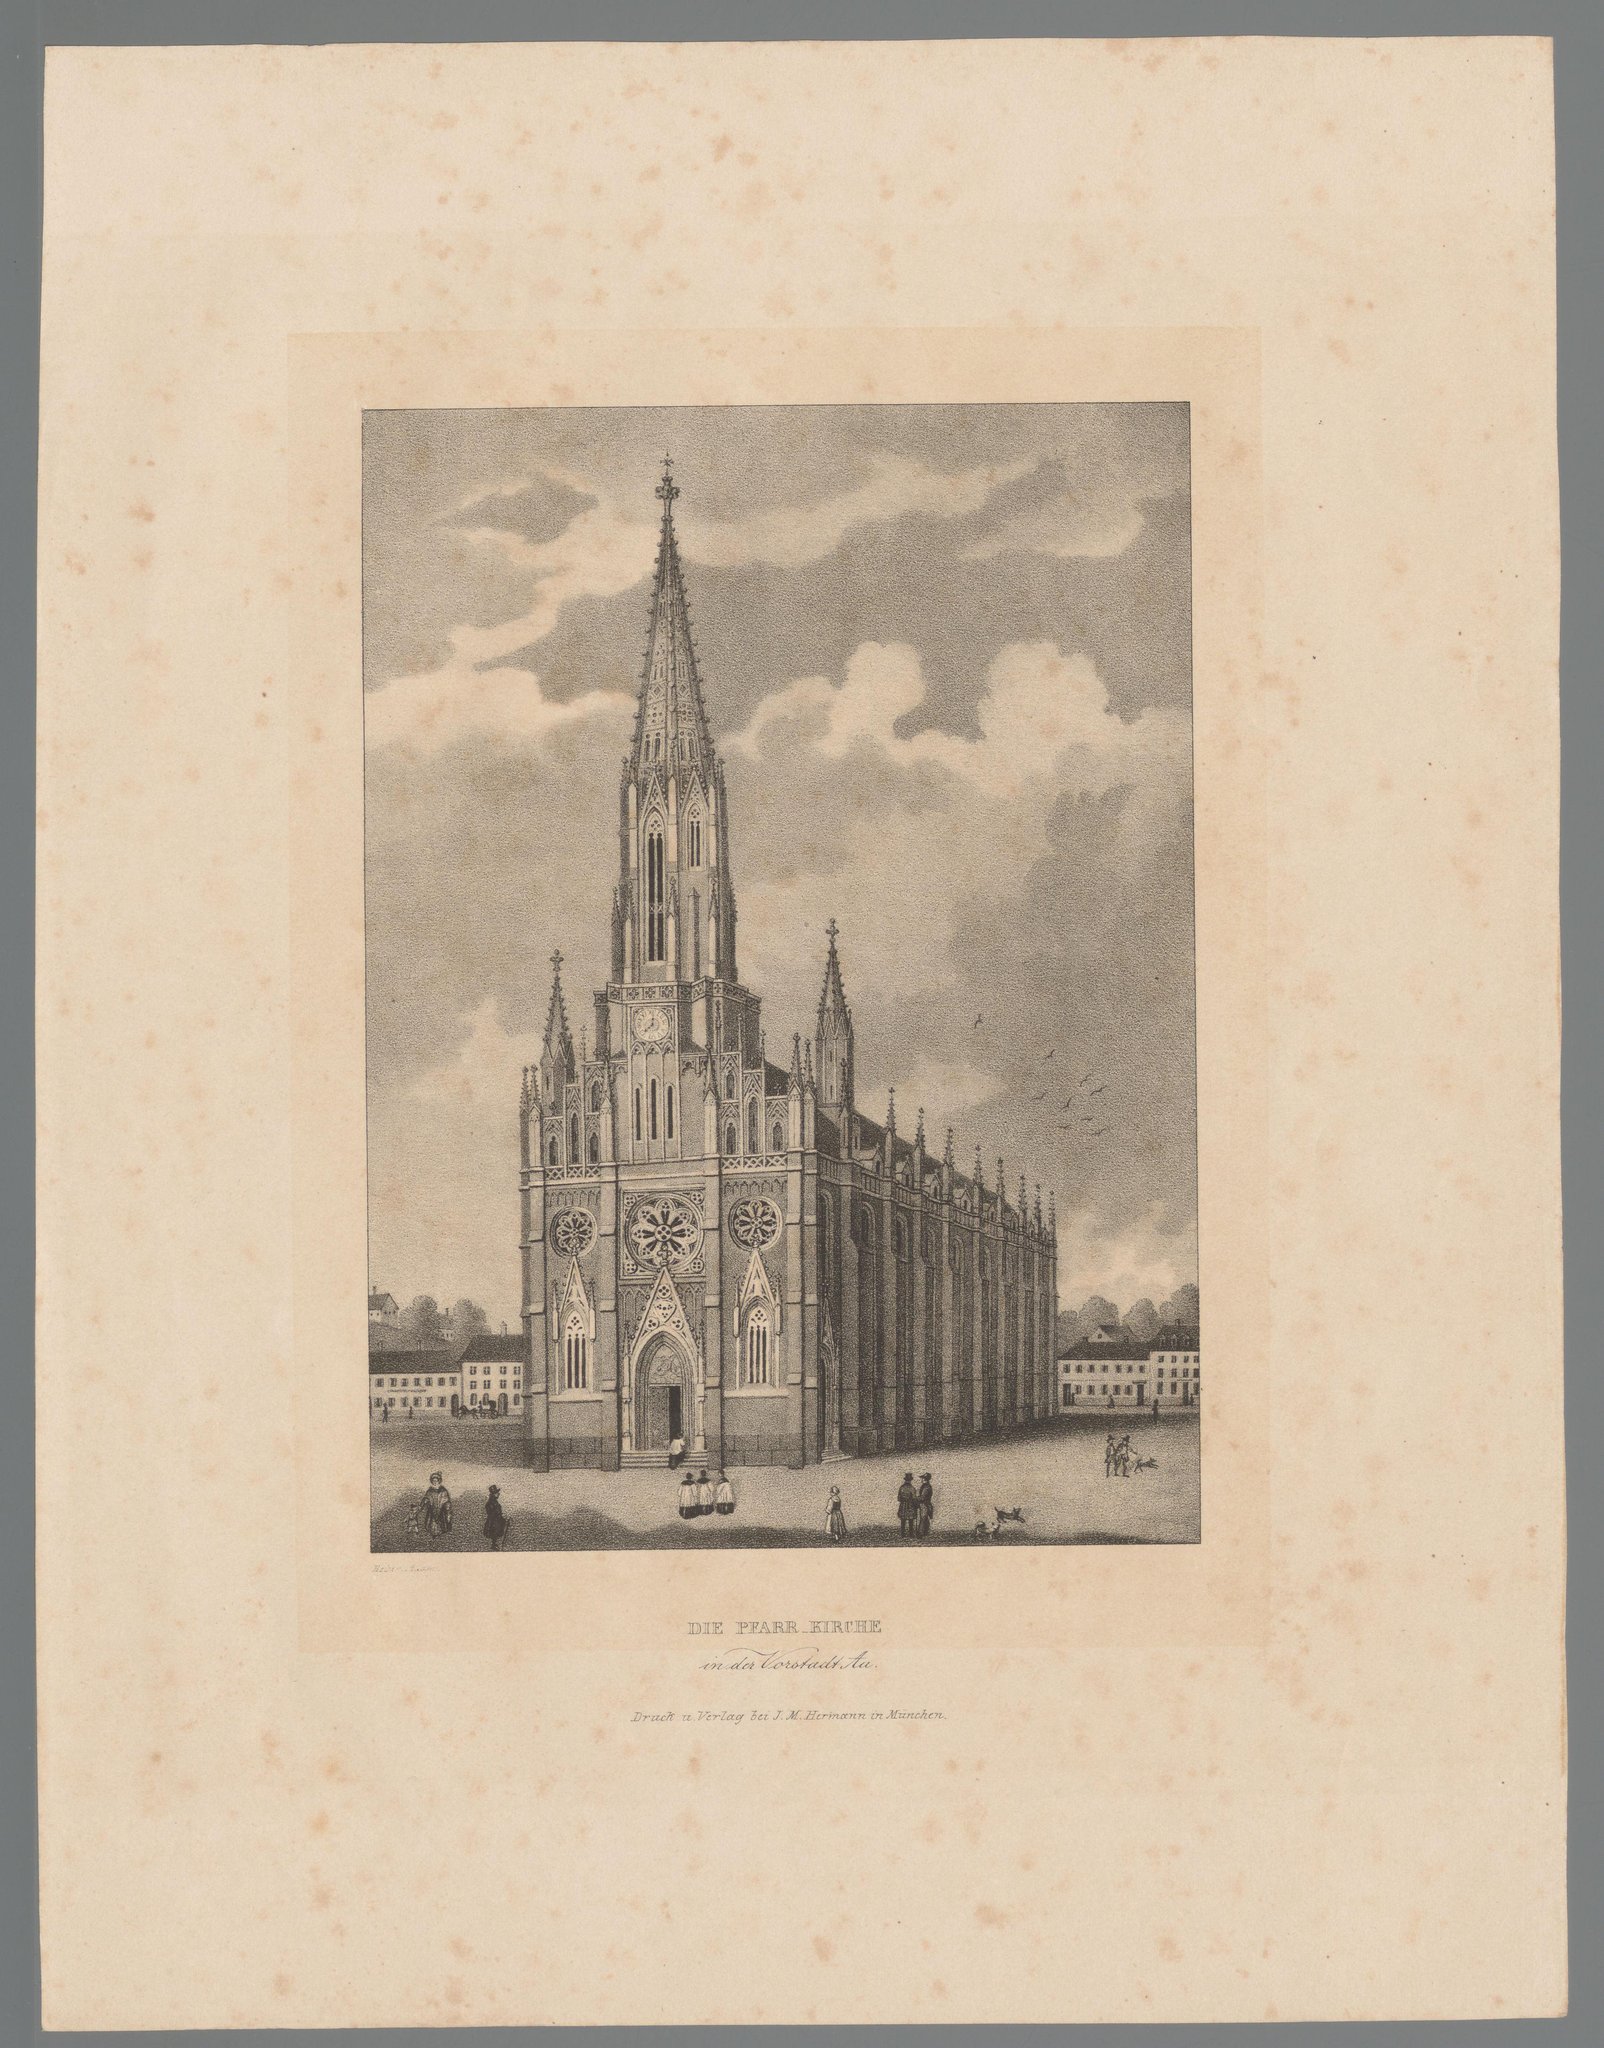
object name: print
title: Die Pfarr-Kirche in der Vorstadt Au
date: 1797-1862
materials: paper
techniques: lithograph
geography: munich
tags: city-view in general; 'veduta', church (exterior)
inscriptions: collector's mark: Lugt 2228